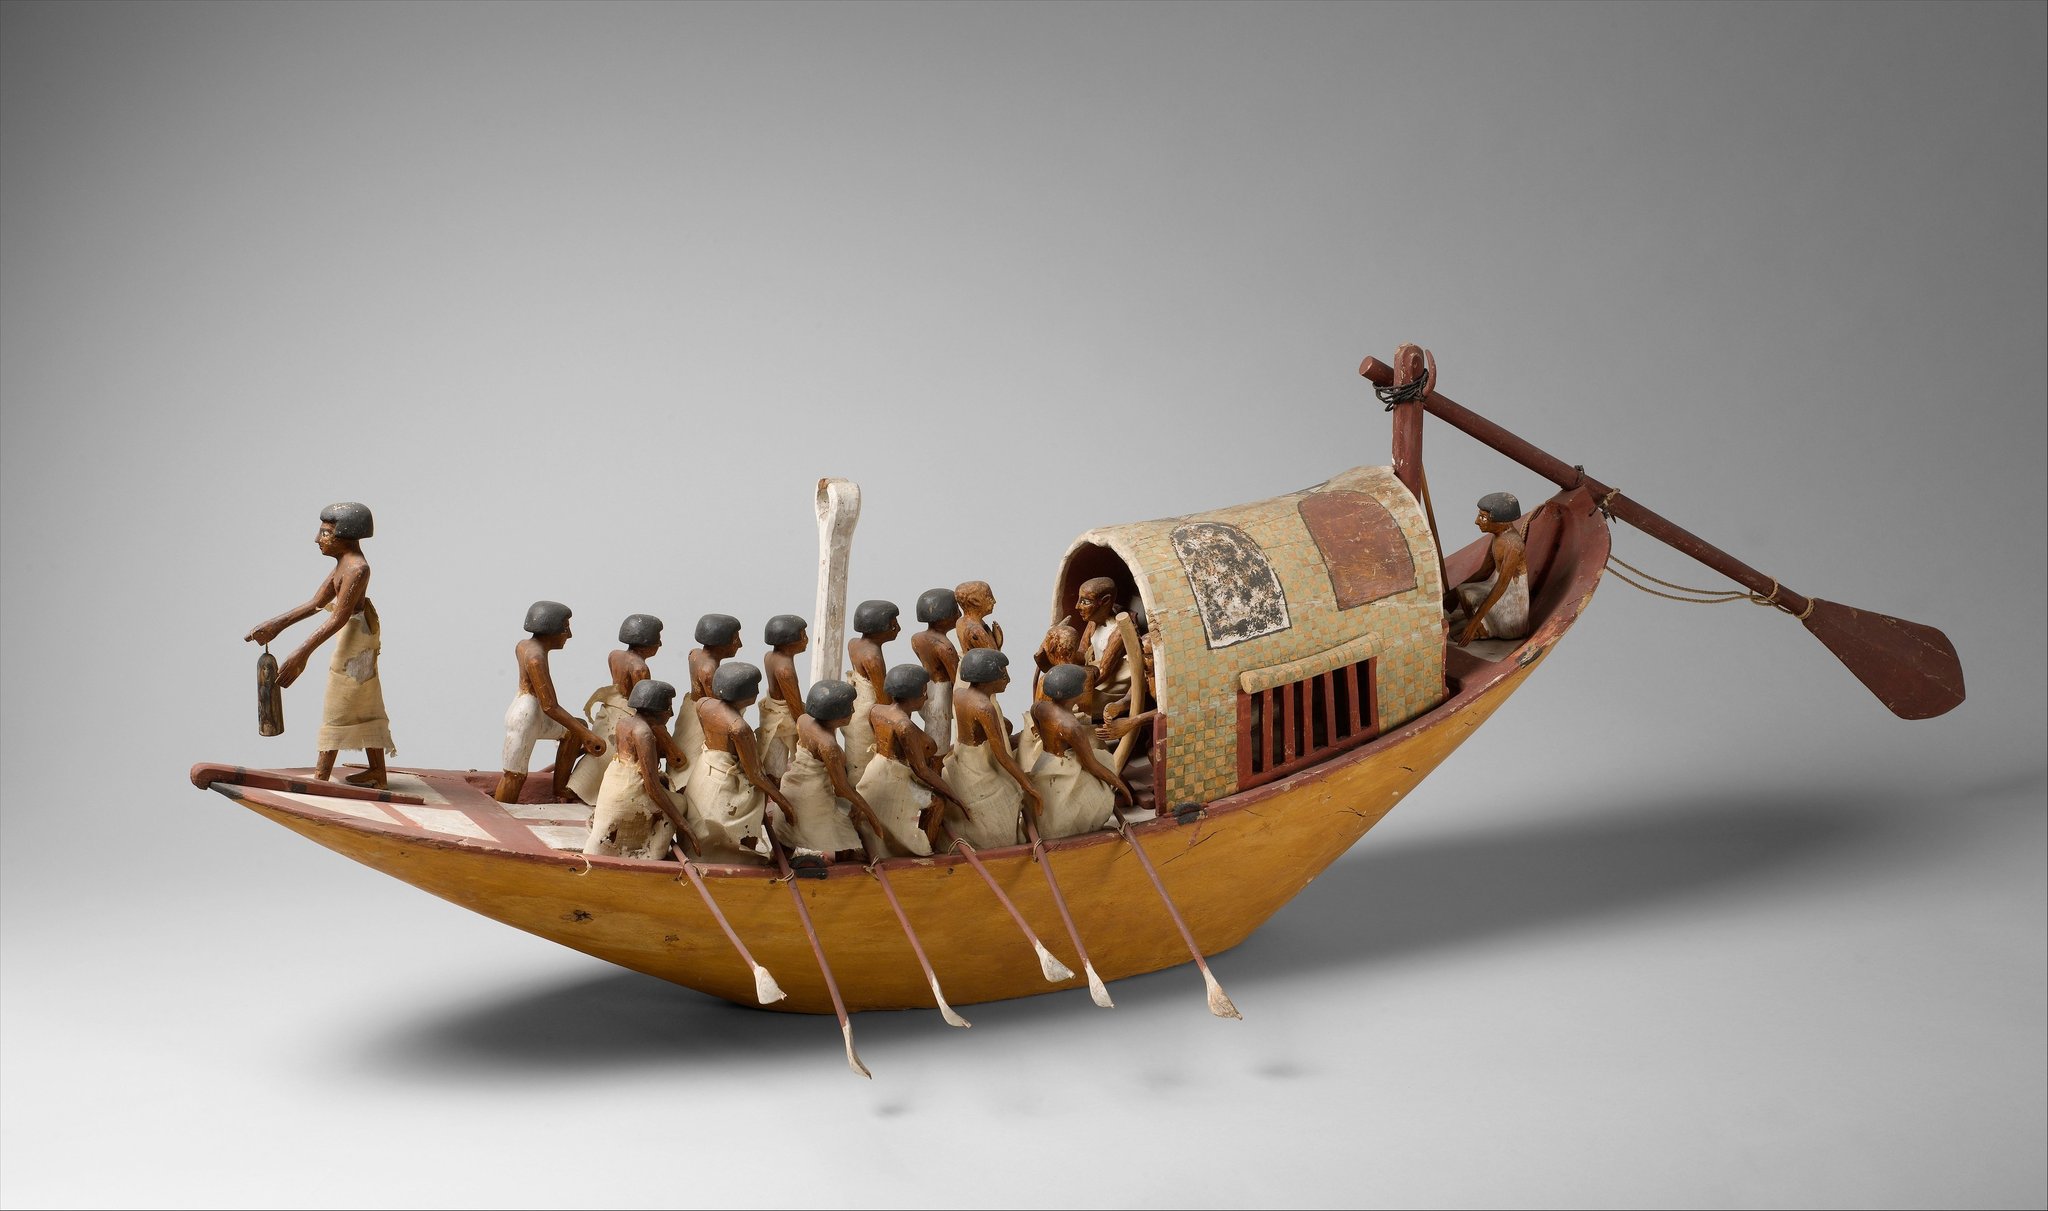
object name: travelling boat, meketre, music, harp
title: Travelling Boat being Rowed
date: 1981-1975 BCE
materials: gesso, linen, paint, wood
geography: egypt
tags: men,boats,meketre-models